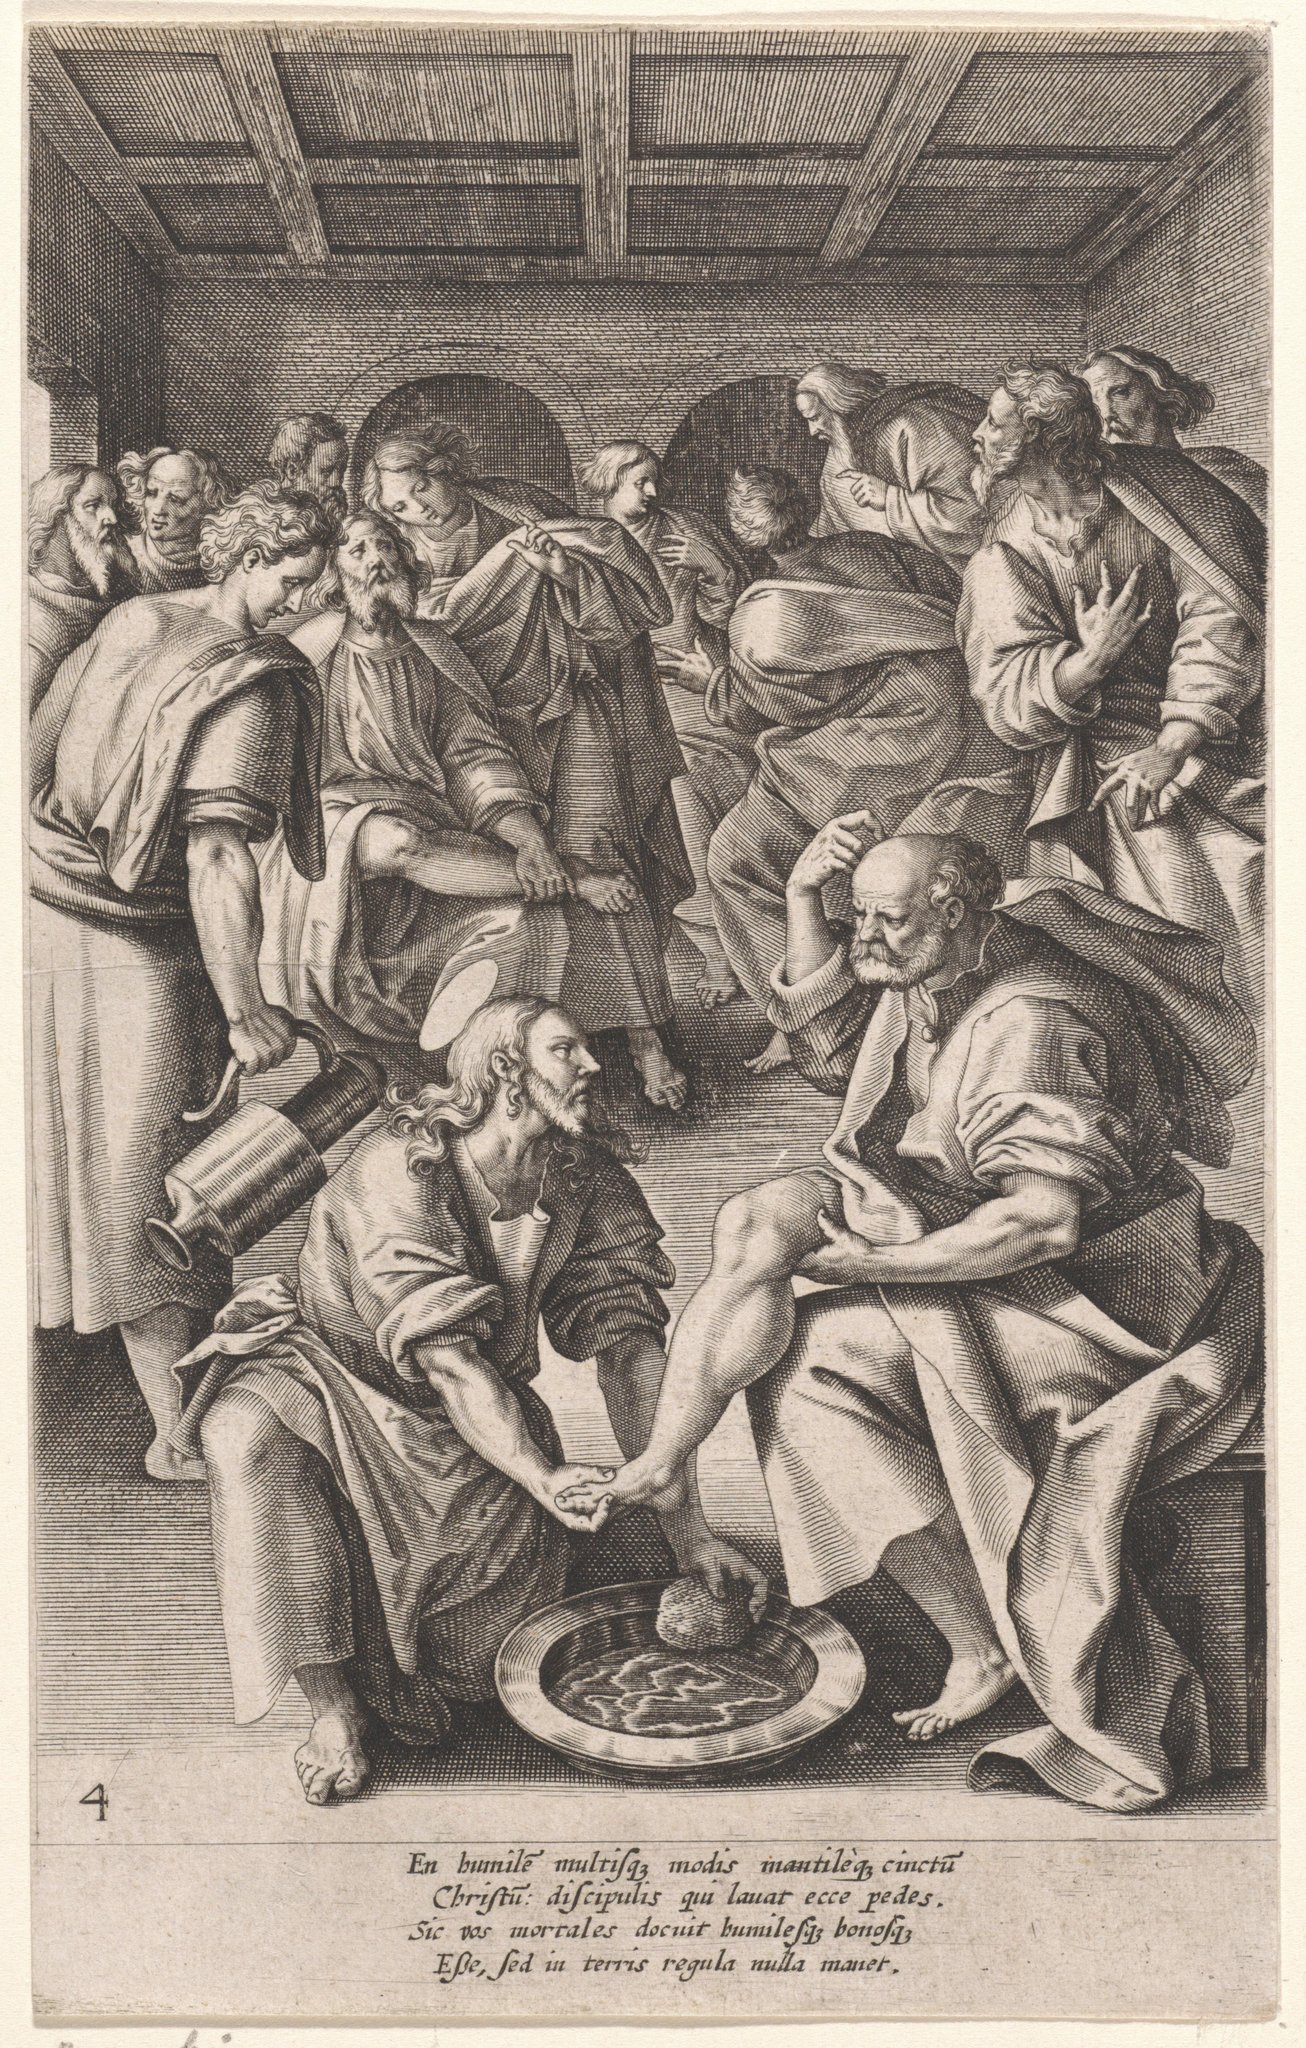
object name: print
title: Dominicæ Passionis Mysteria Typicis Advmbrationibvs Adamussim Effigiata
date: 1583-1587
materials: paper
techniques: engraving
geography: antwerp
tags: christ washes peter's feet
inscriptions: collector's mark: Lugt 2228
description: Prent gebruikt in: Thesaurus sacrarum historiaru[m] veteris (et novi) testame[n]ti, elega[n]tissimis imaginibus expressu[m] excelle[n]tissimoru[m] in hac arte viroru[m] opera : nu[n]c primu[m] in luce[m] editus. Antwerpen: Gerard de Jode, 1585.